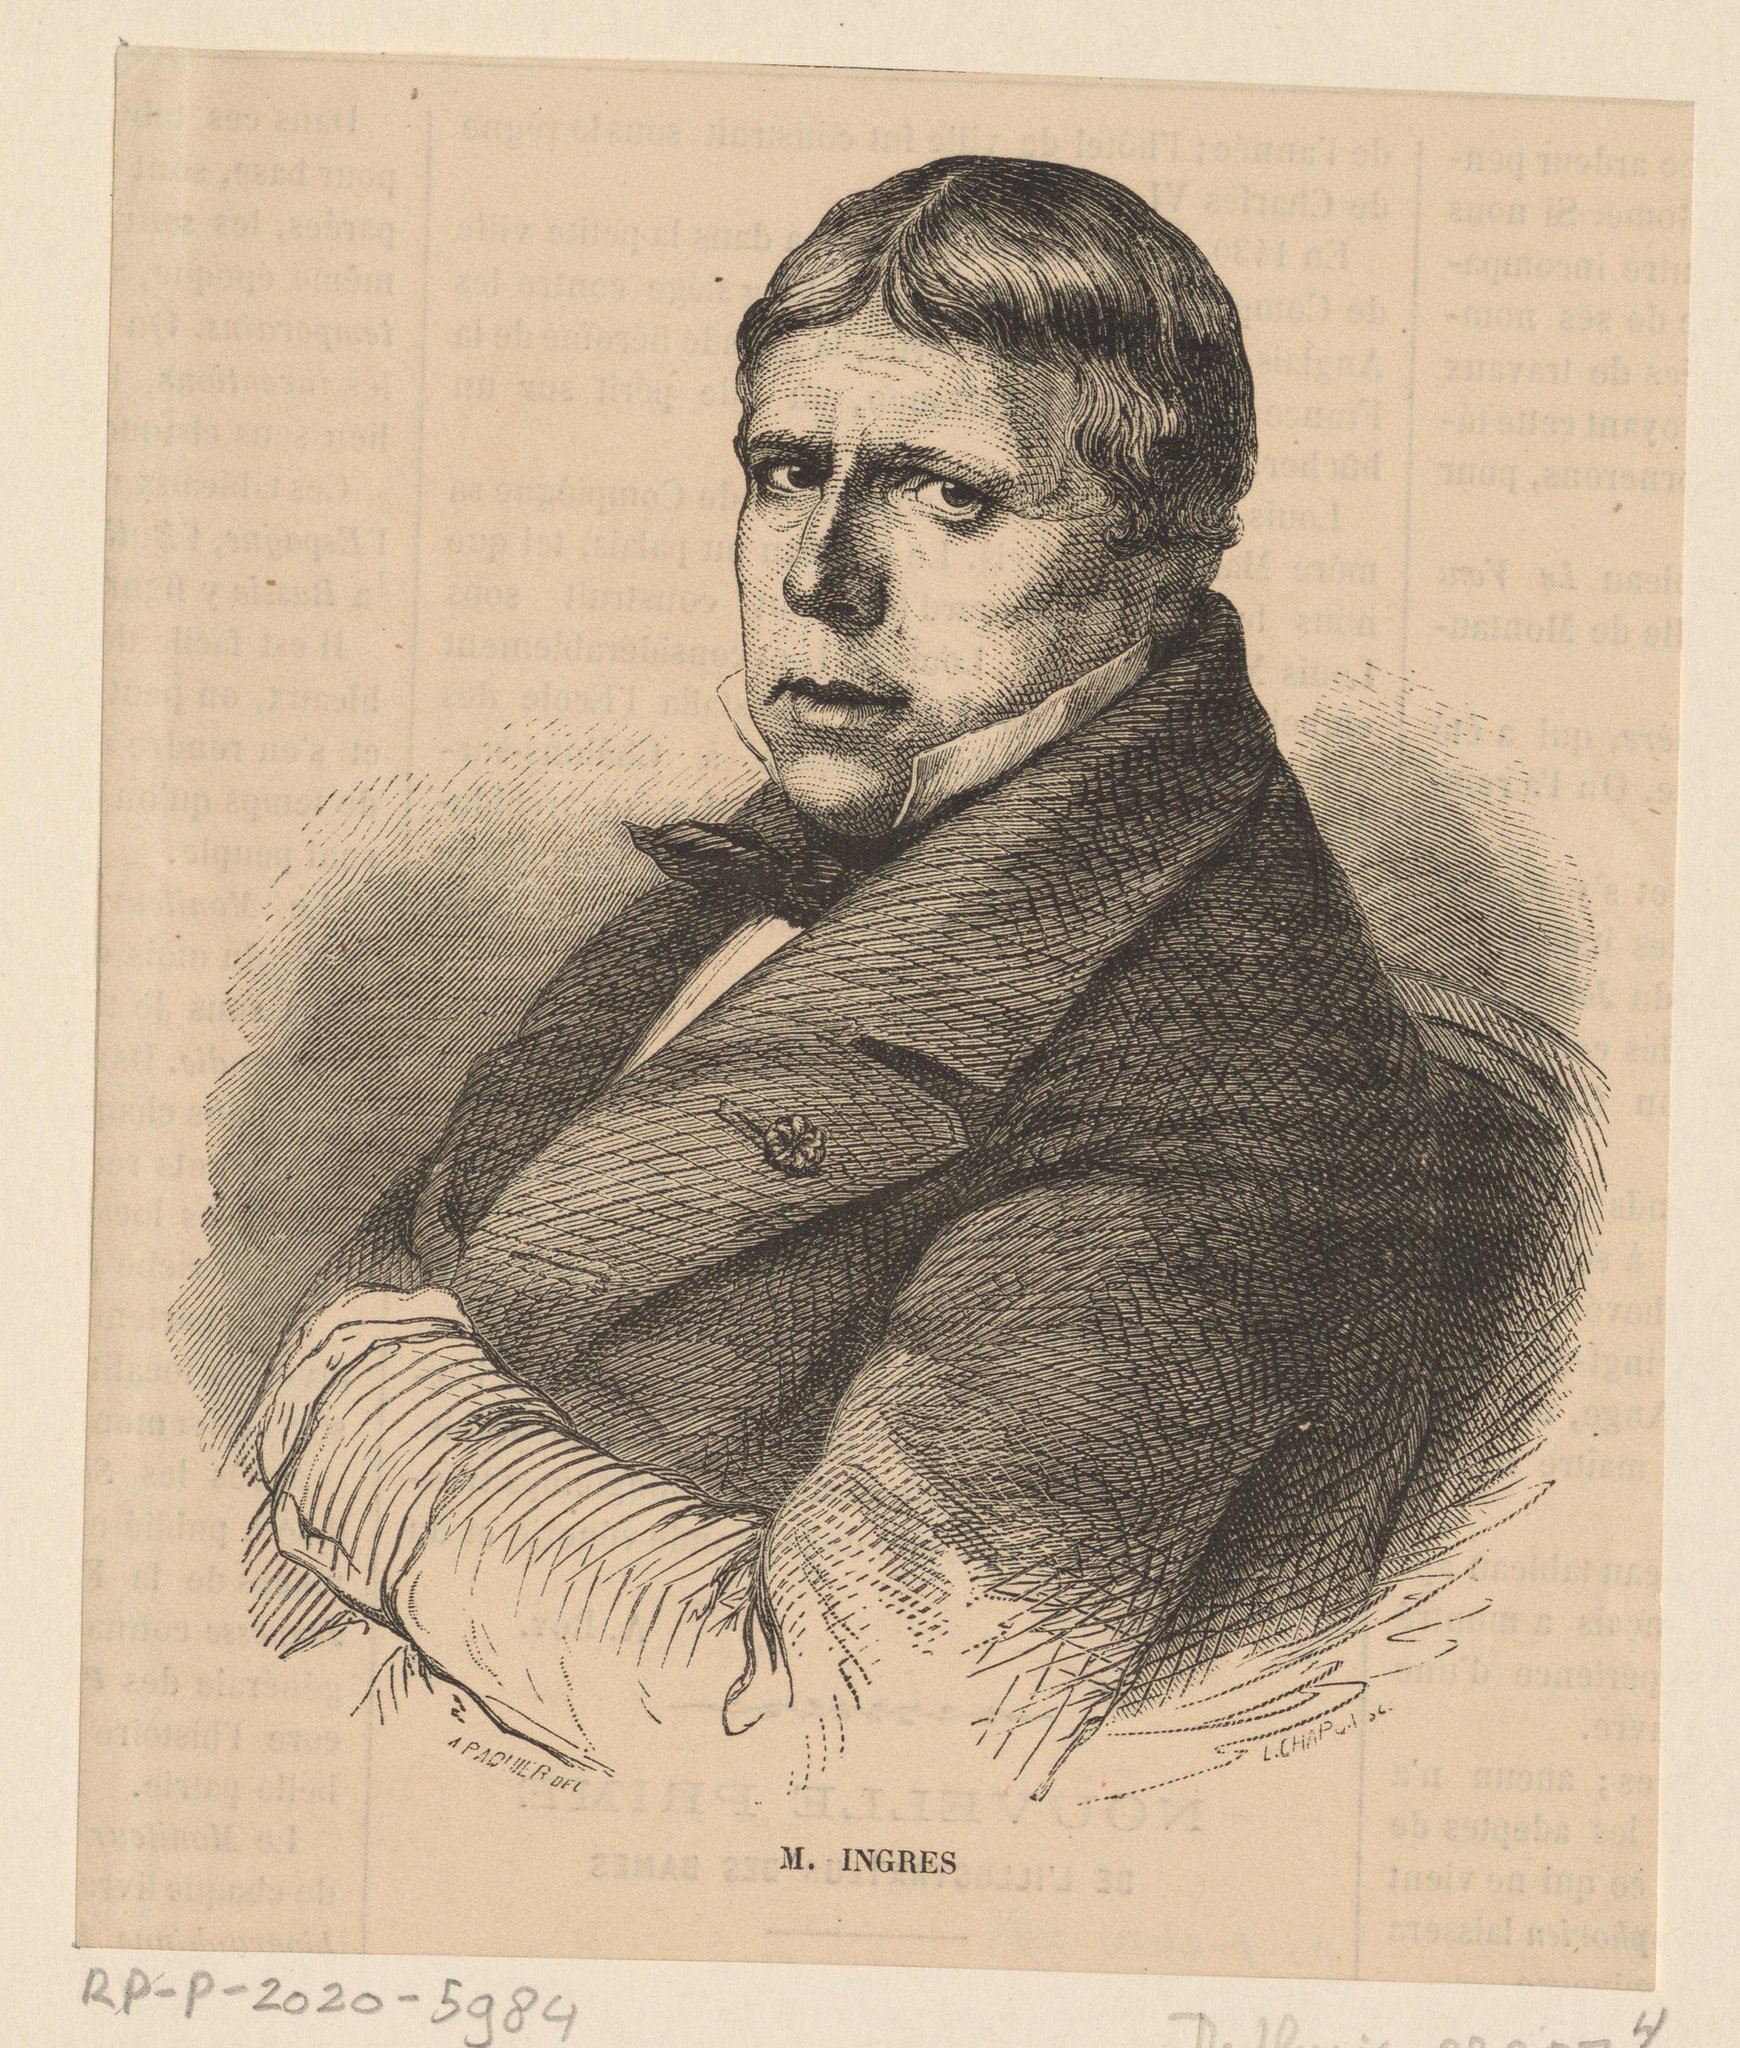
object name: print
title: Portret van Jean Auguste Dominique Ingres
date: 1846-1918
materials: paper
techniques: letterpress printing, engraving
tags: paris, print maker, draughtsman, jean auguste dominique ingres, historical persons, portrait, self-portrait of painter